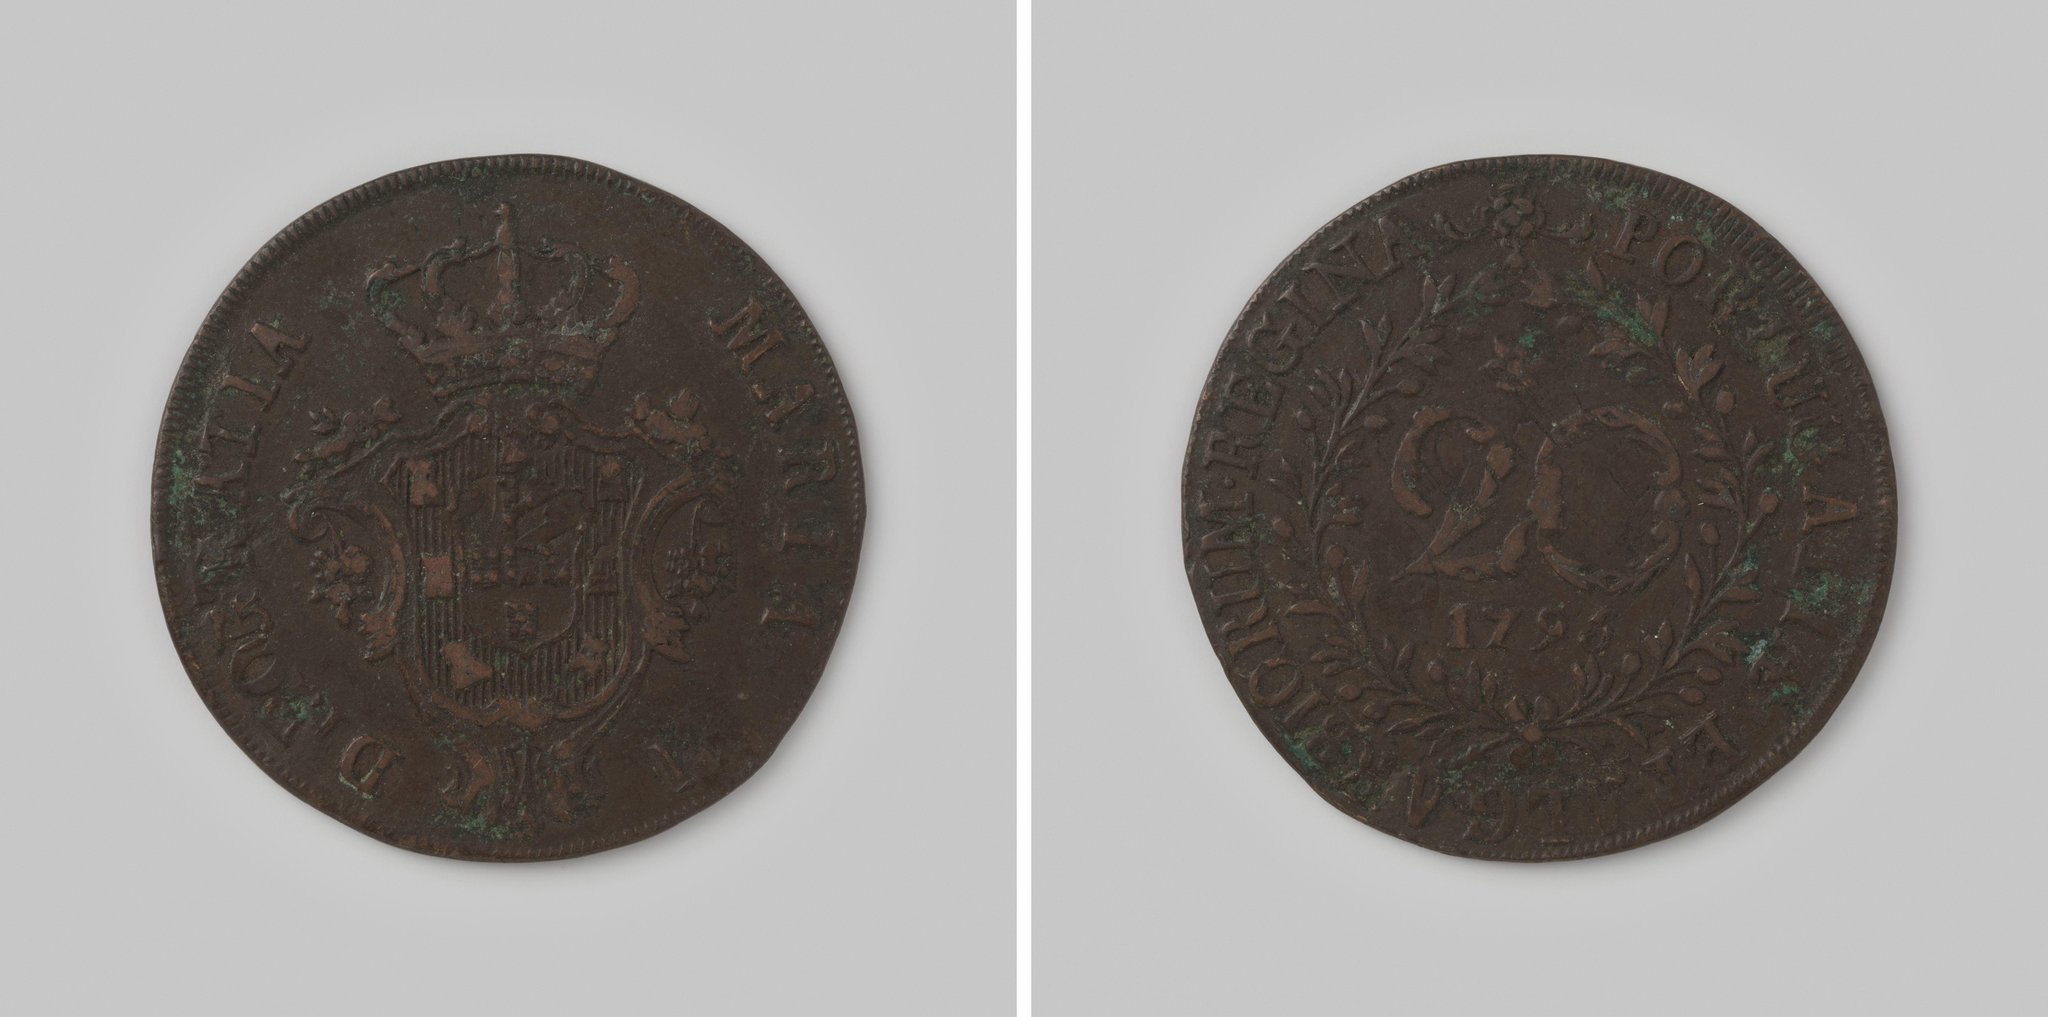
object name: coin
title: Azoren, koningin Maria I van Portugal, 20 reis, 1795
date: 1795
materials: copper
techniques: striking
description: Koperen munt. Voorzijde: barok wapenschild van Portugal, waarboven kroon. tussen twee samengebonden takken waarde-aanduiding: 20, waaronder jaartal. Gladde rand.